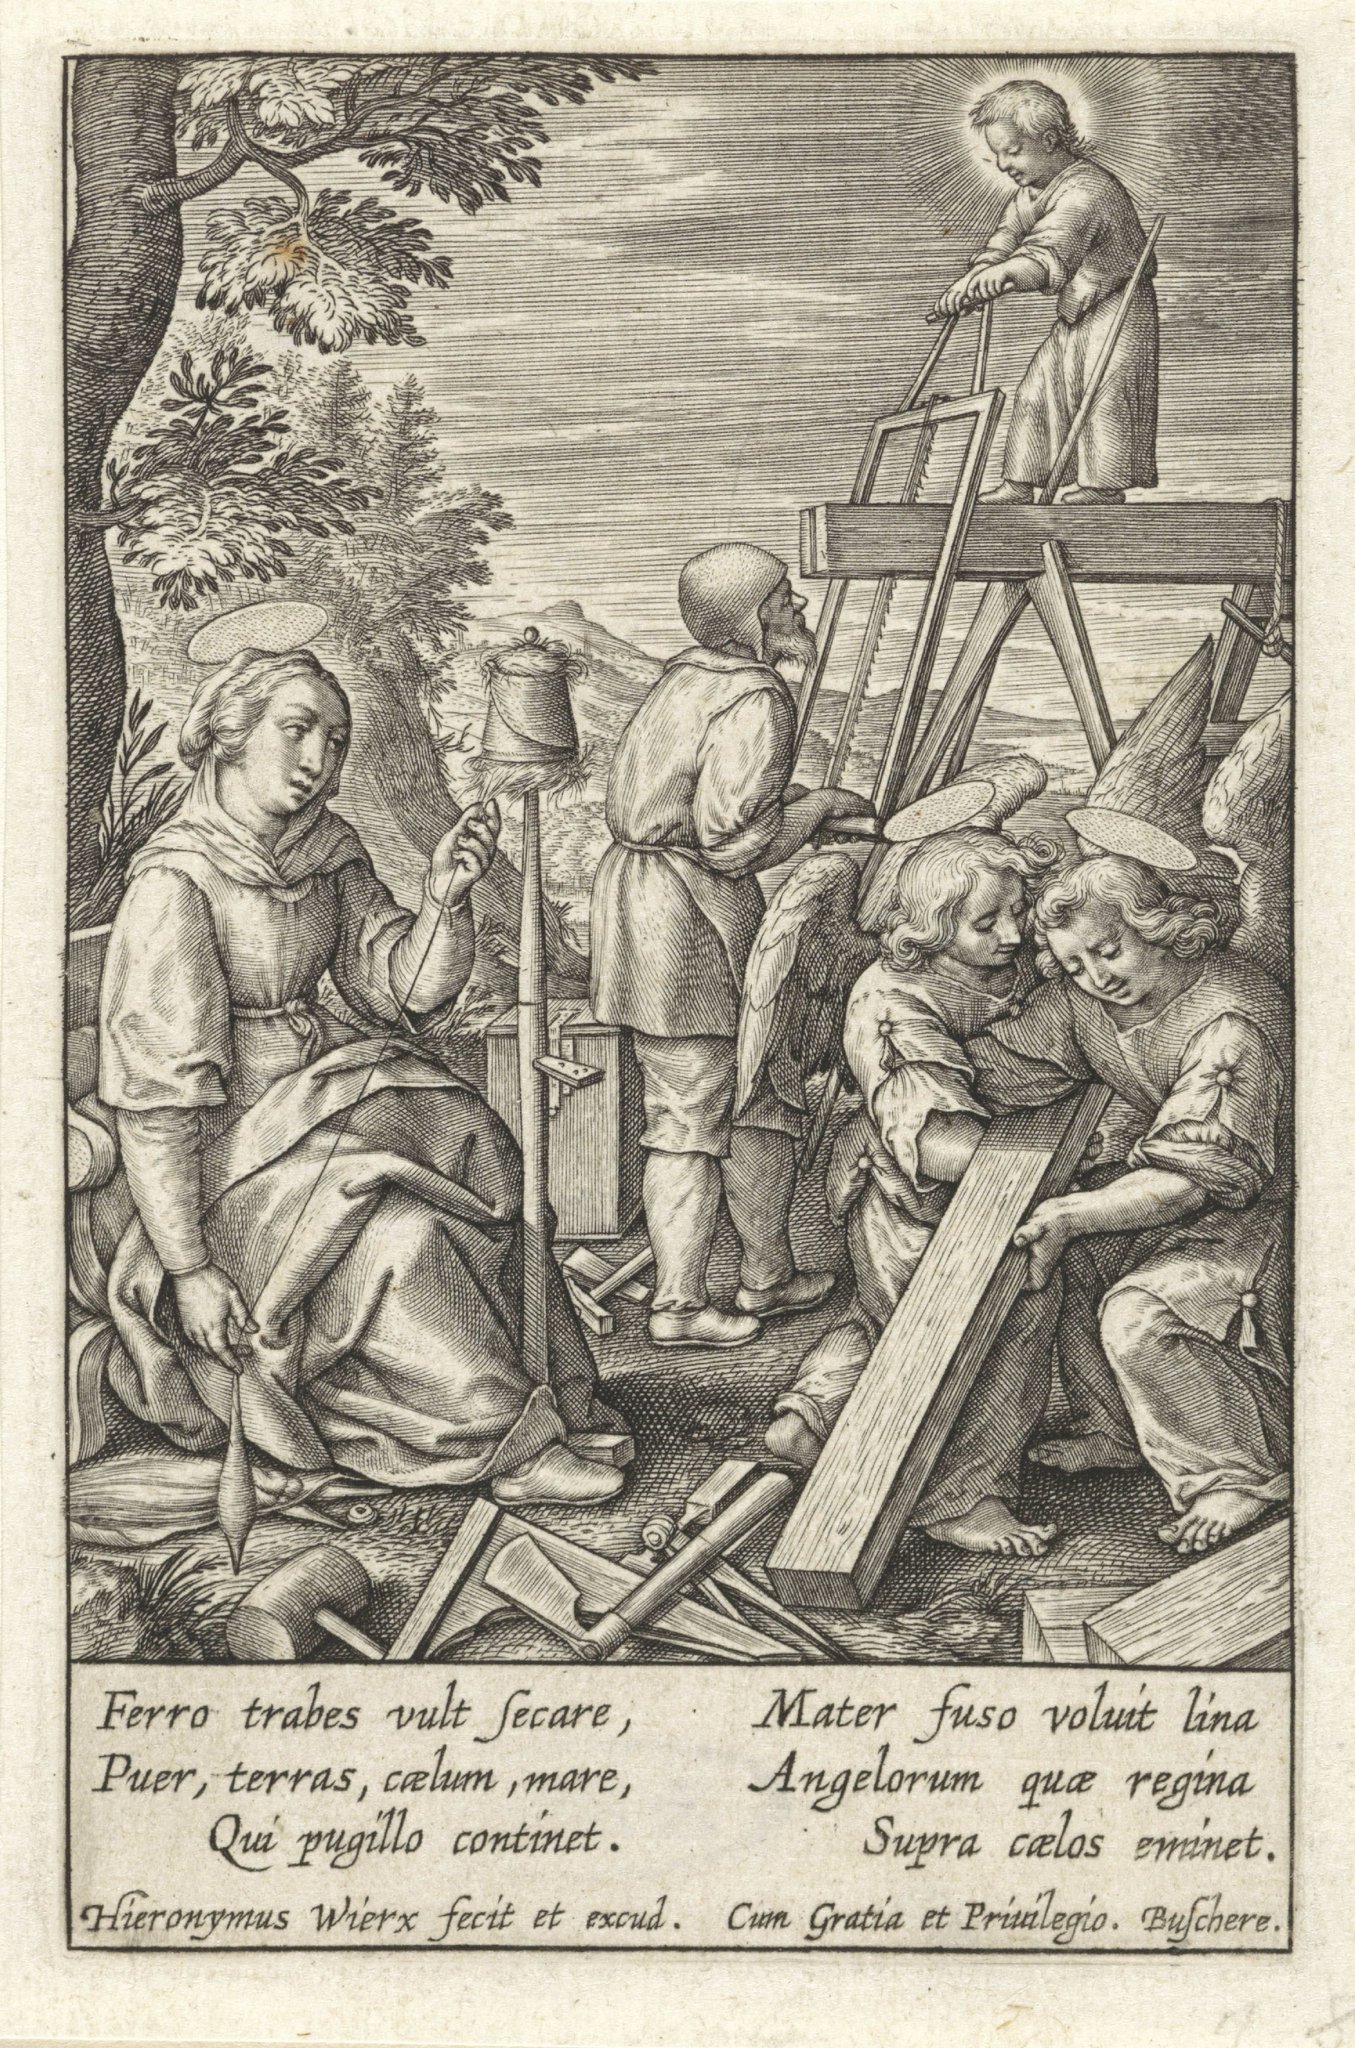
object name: print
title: Christuskind helpt Jozef met zagen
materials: paper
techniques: engraving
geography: antwerp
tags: joseph and the christ-child ~ daily life in nazareth, household occupations of mary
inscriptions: collector's mark: Lugt 2228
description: Het Christuskind is samen met zijn vader Jozef aan het zagen. Twee engelen op de voorgrond tillen een balk op. Maria is garen aan het spinnen. In de marge een zesregelig onderschrift, in twee kolommen, in het Latijn.